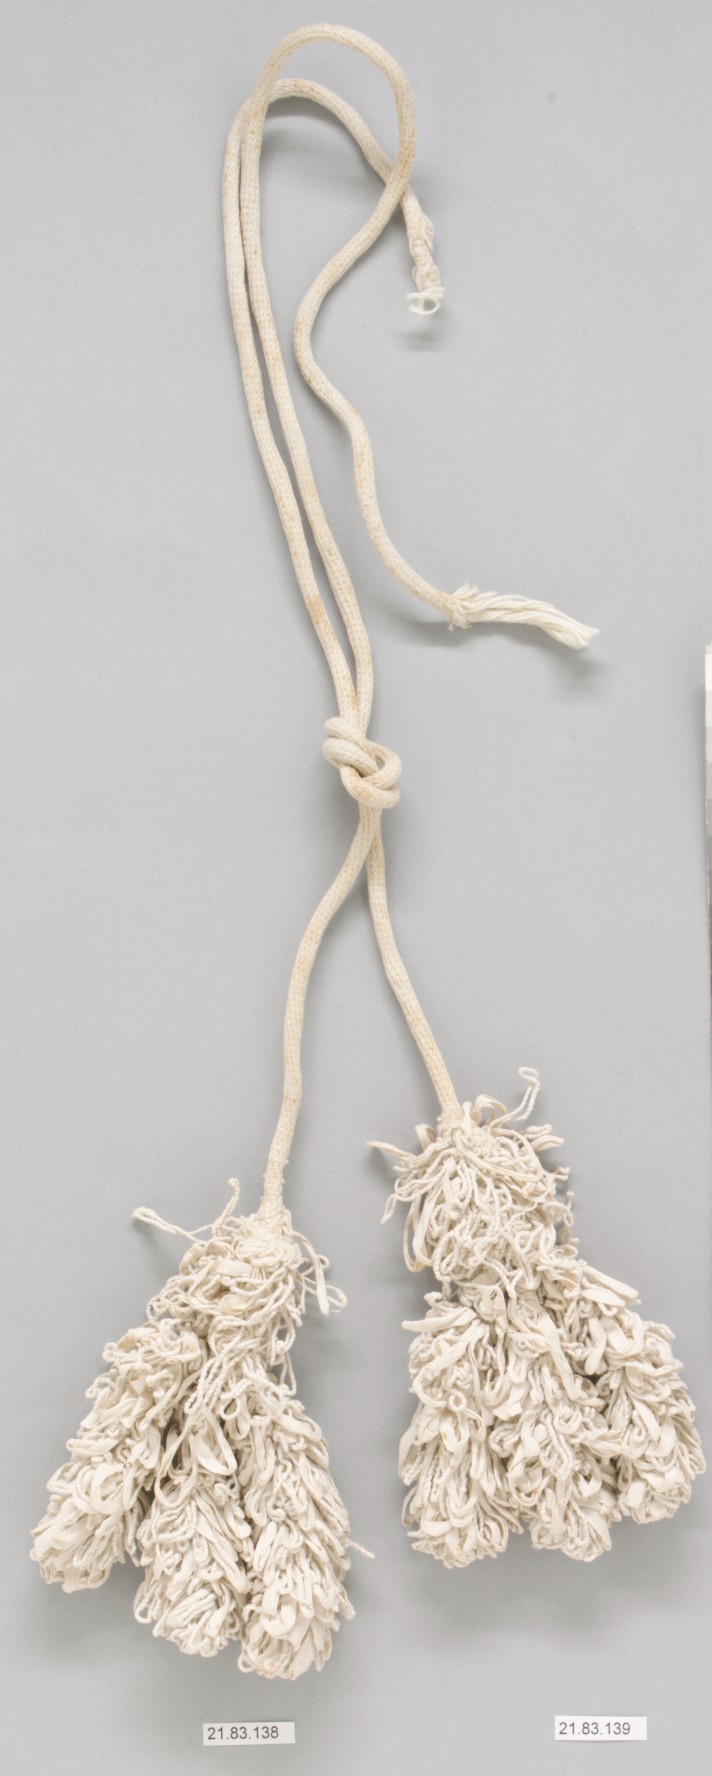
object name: tassel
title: Pair of tassels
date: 1601-1700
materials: linen